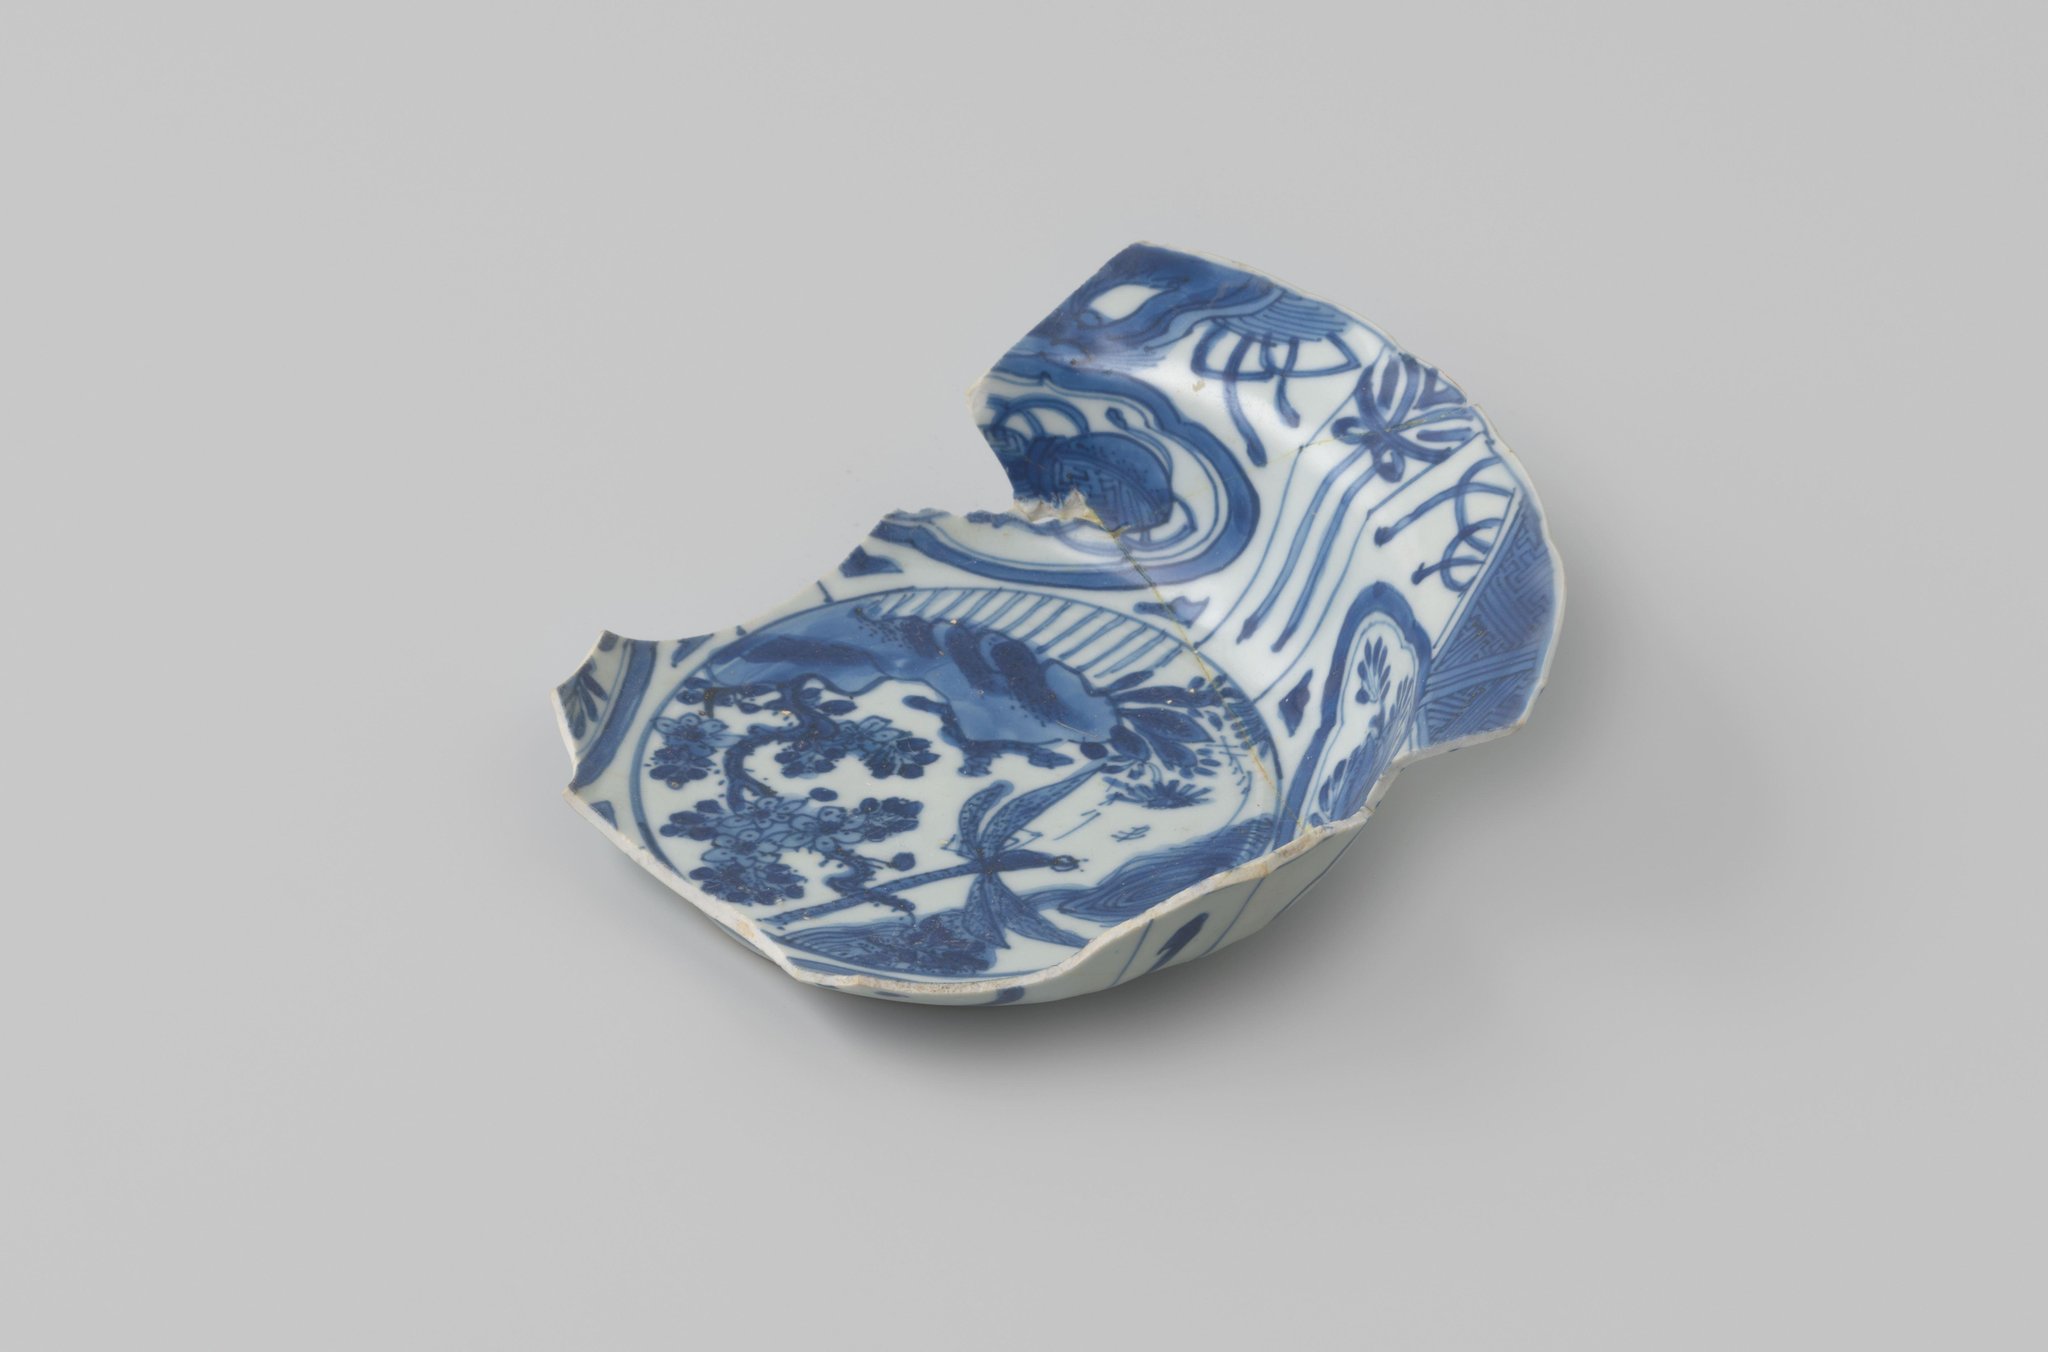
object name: sherd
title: Fragment diep bord uit V.O.C.-schip de 'Witte Leeuw'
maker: Anonymous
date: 1613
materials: bone china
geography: jingdezhen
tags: verenigde oostindische compagnie, sint-helena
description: A bowl with a flattened rim. Taotie mask and/or borders with diaper patterns. A central decoration of a grasshopper on a rock next to a peony. Panels decorated with flowers and fruits.